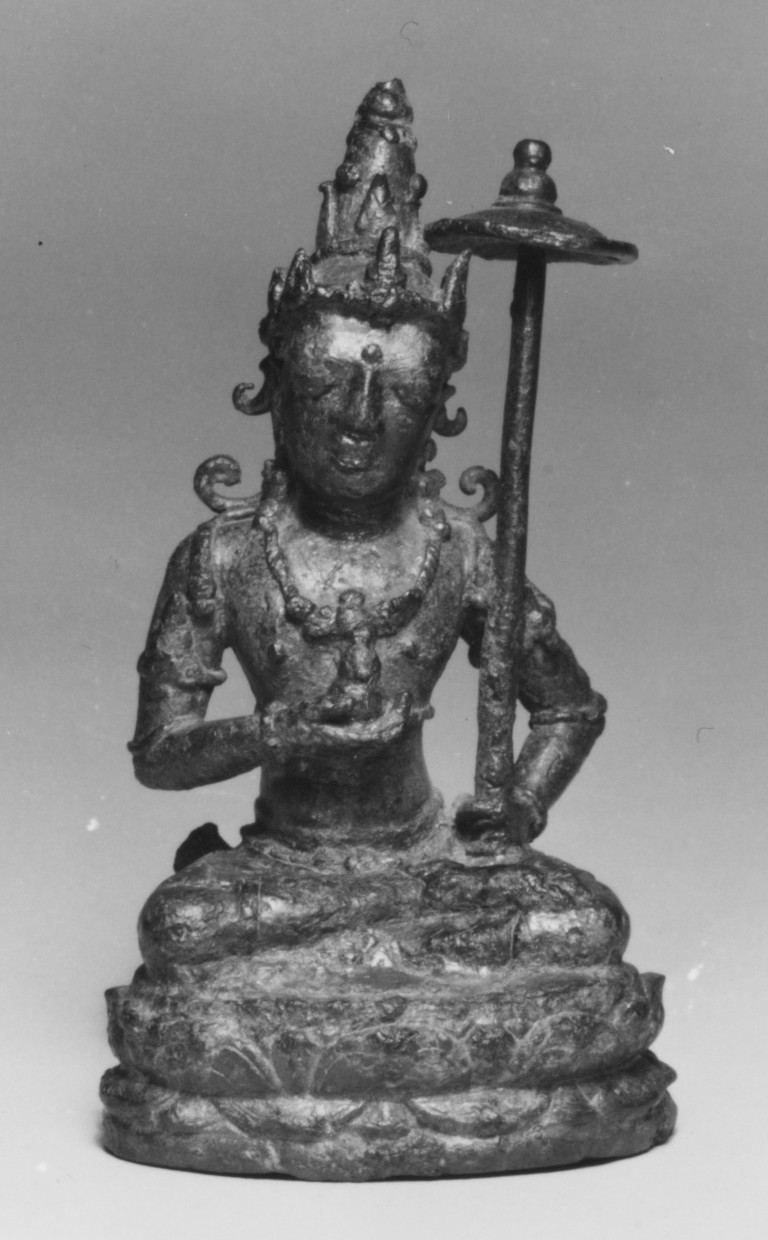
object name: figurine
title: Seated Male Deity Holding a Parasol and an Unidentified Object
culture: indonesian, java, ngandjuk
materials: bronze